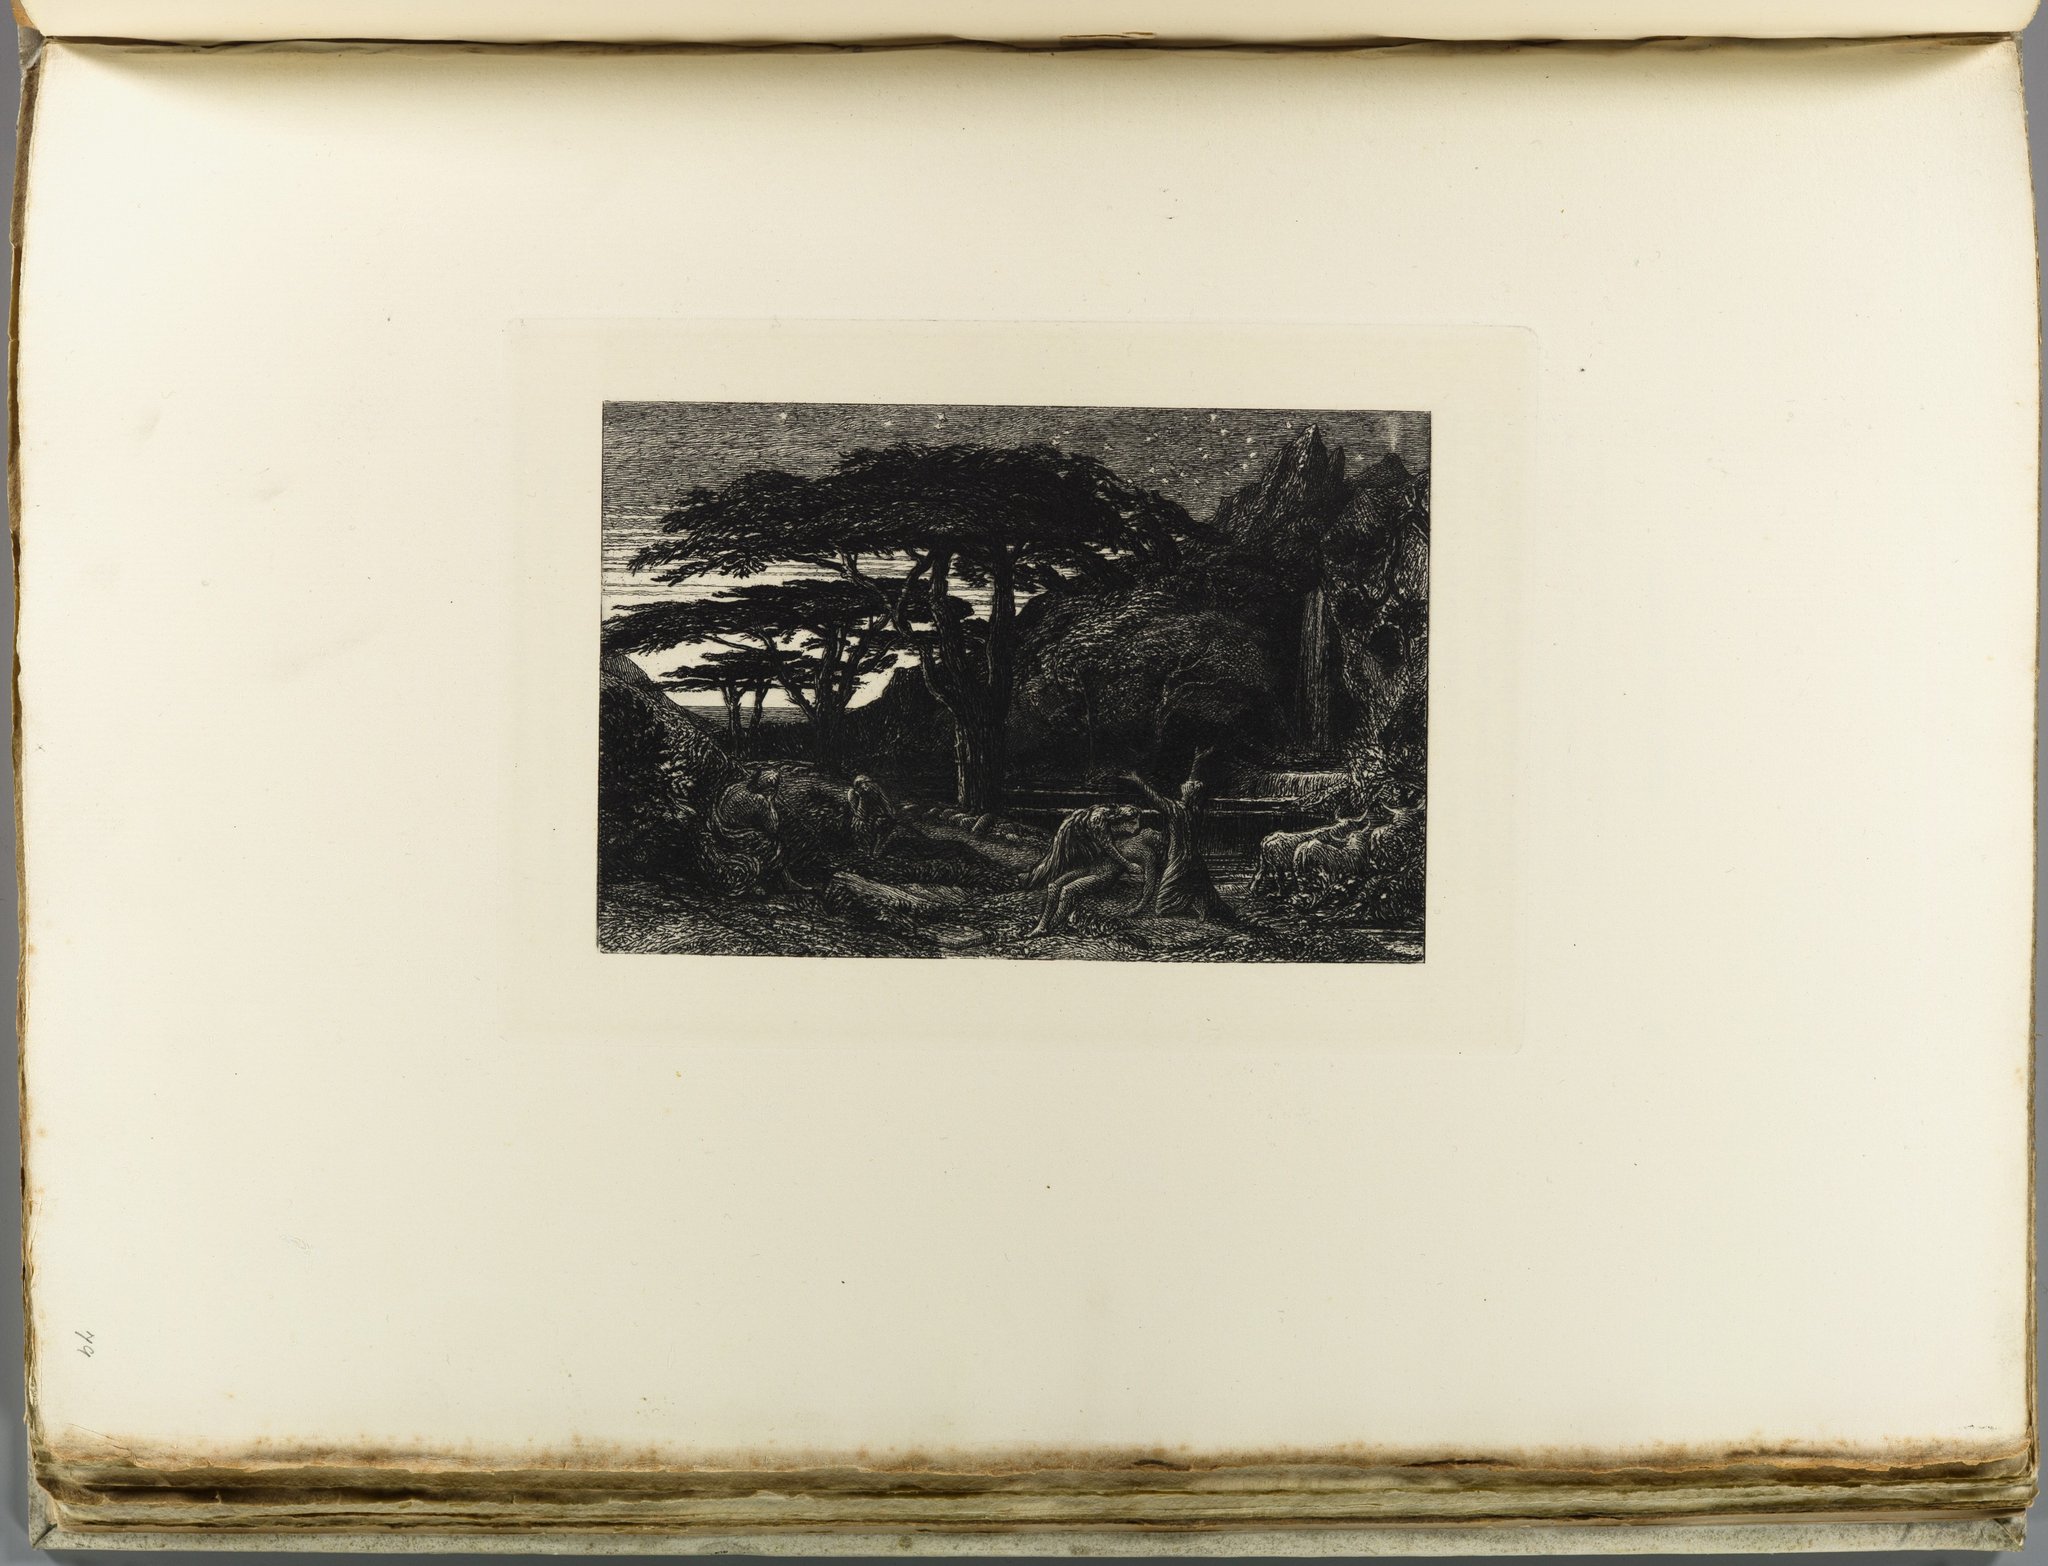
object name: book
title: An English Version of the Eclogues of Virgil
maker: virgil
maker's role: author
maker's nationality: italian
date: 1883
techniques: drawing, etching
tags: men,women,landscapes,trees